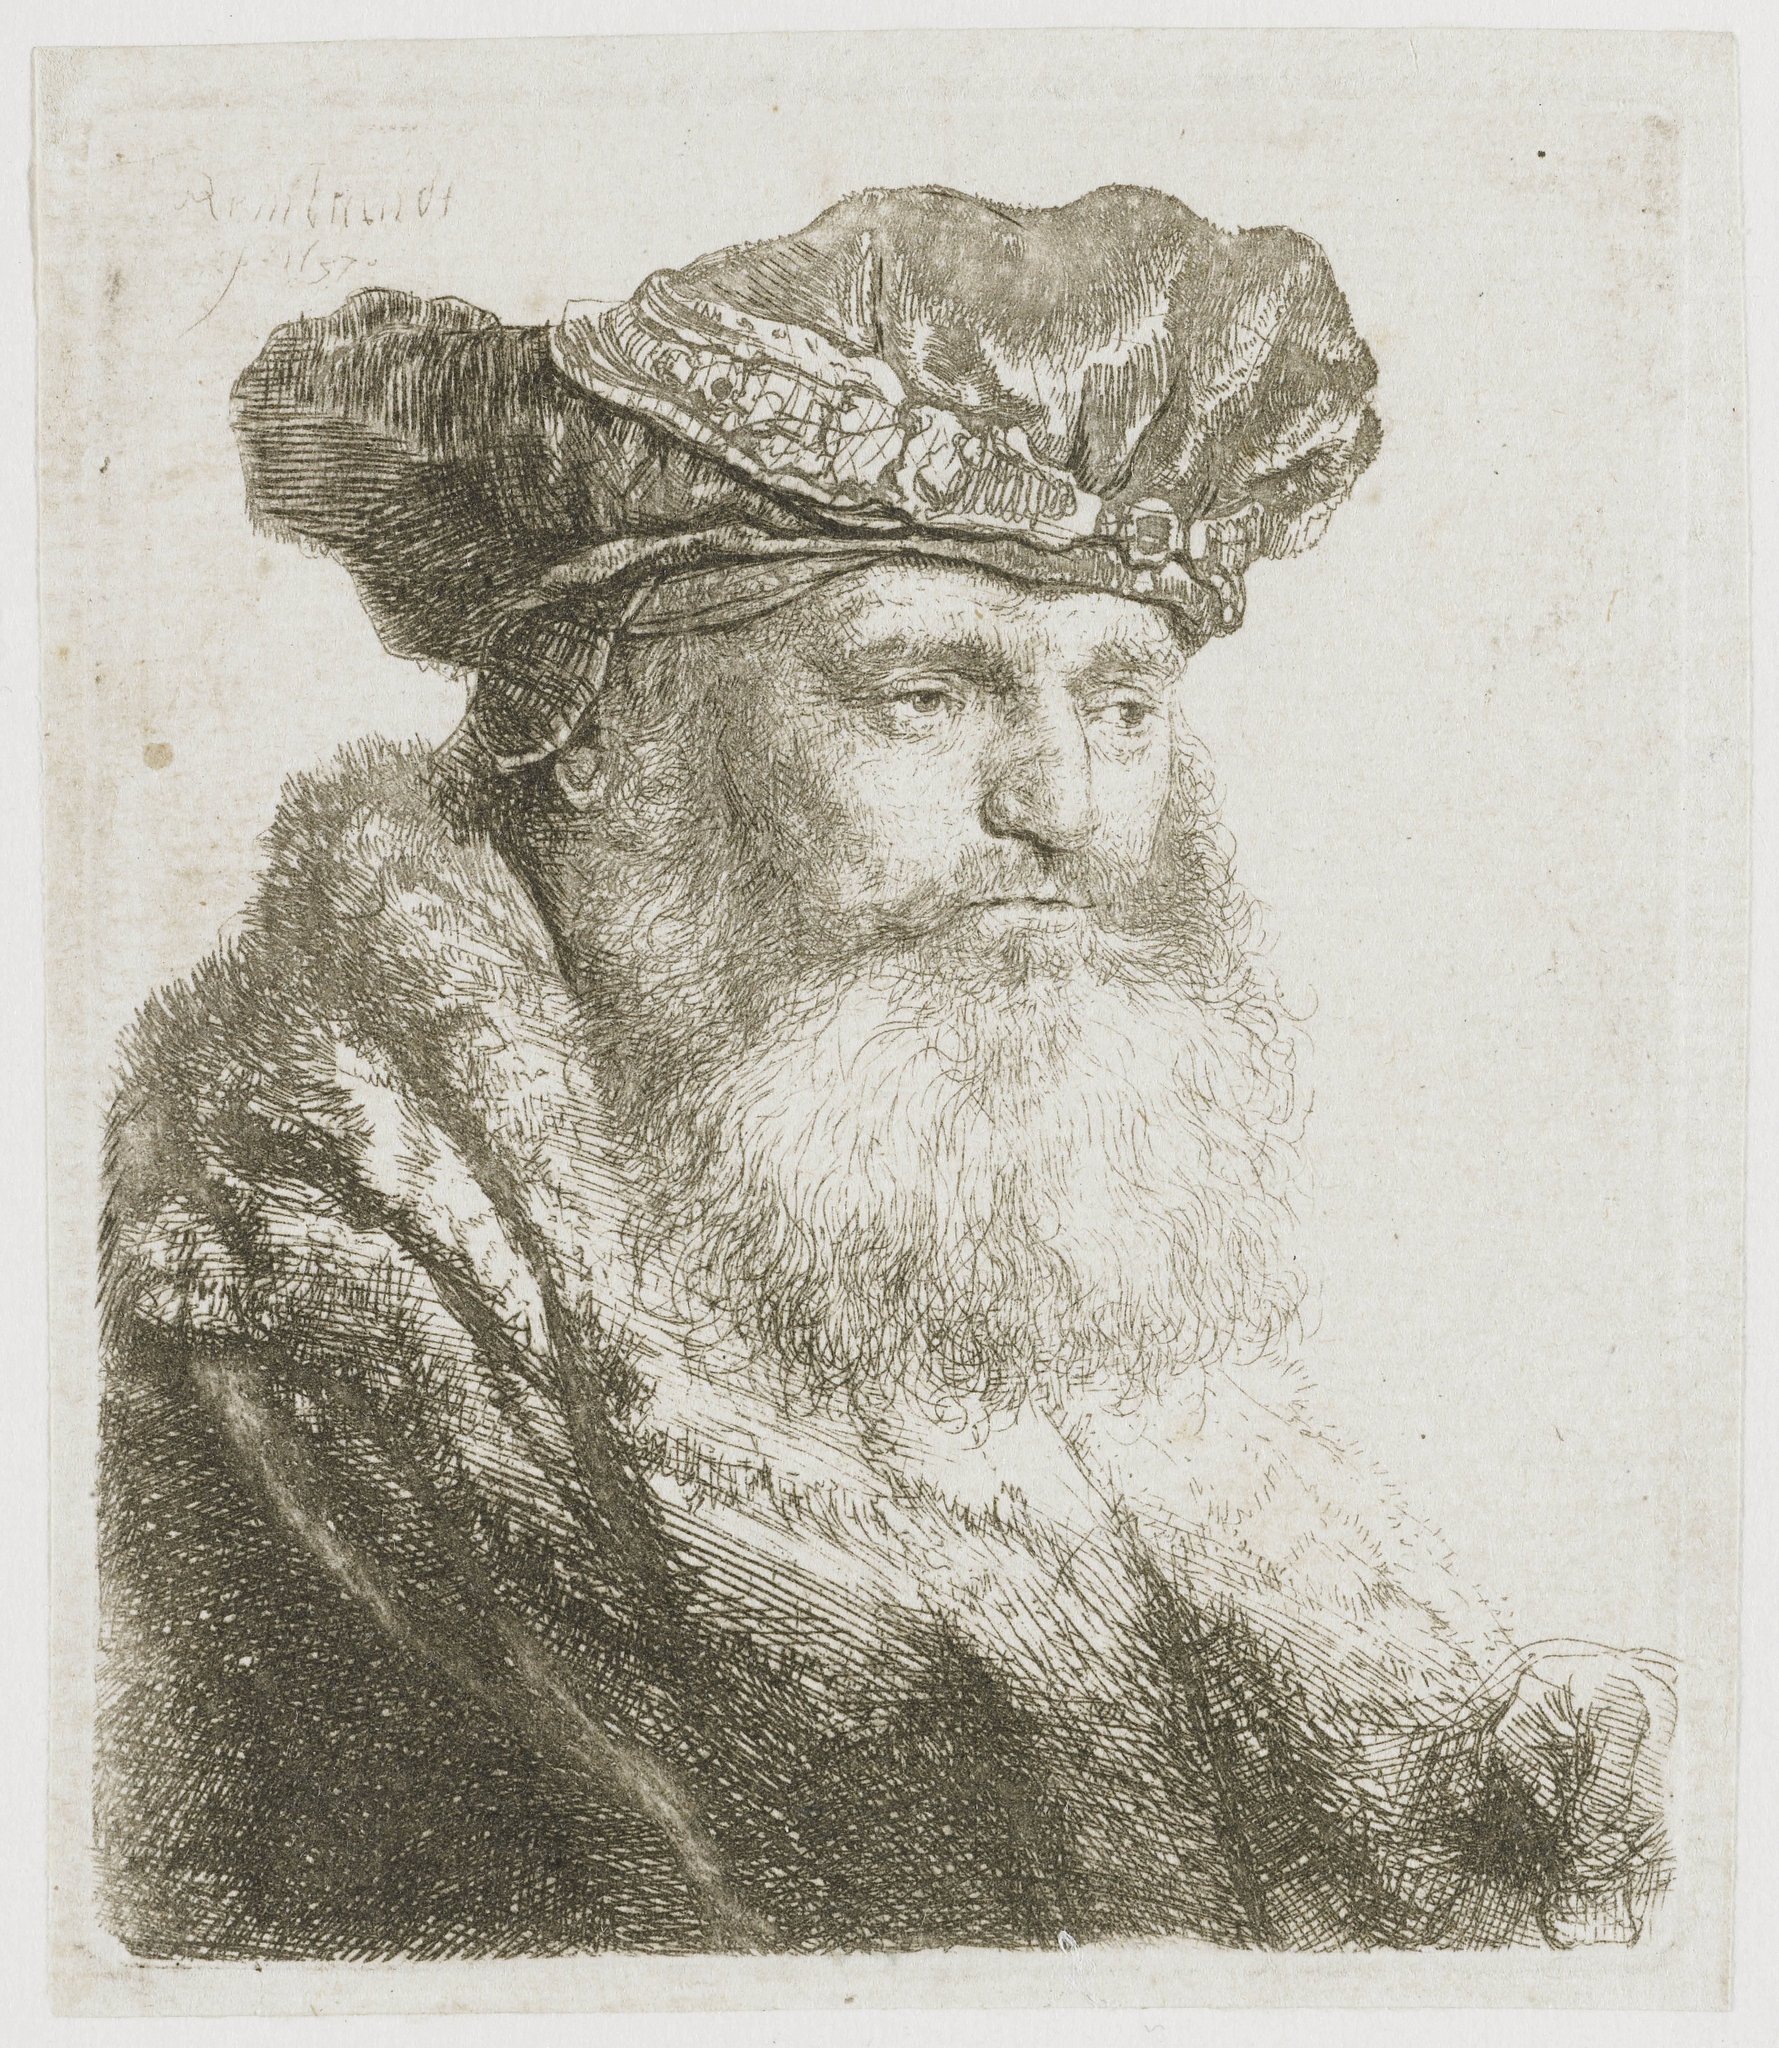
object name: print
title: Bearded man in a velvet cap with a jewel clasp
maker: rembrandt van rijn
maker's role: draughtsman, painter, print maker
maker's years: 1606-1669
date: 1637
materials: paper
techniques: etching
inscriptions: signature and date: ‘Rembrandt f 1637’, collector's mark: Lugt 2165